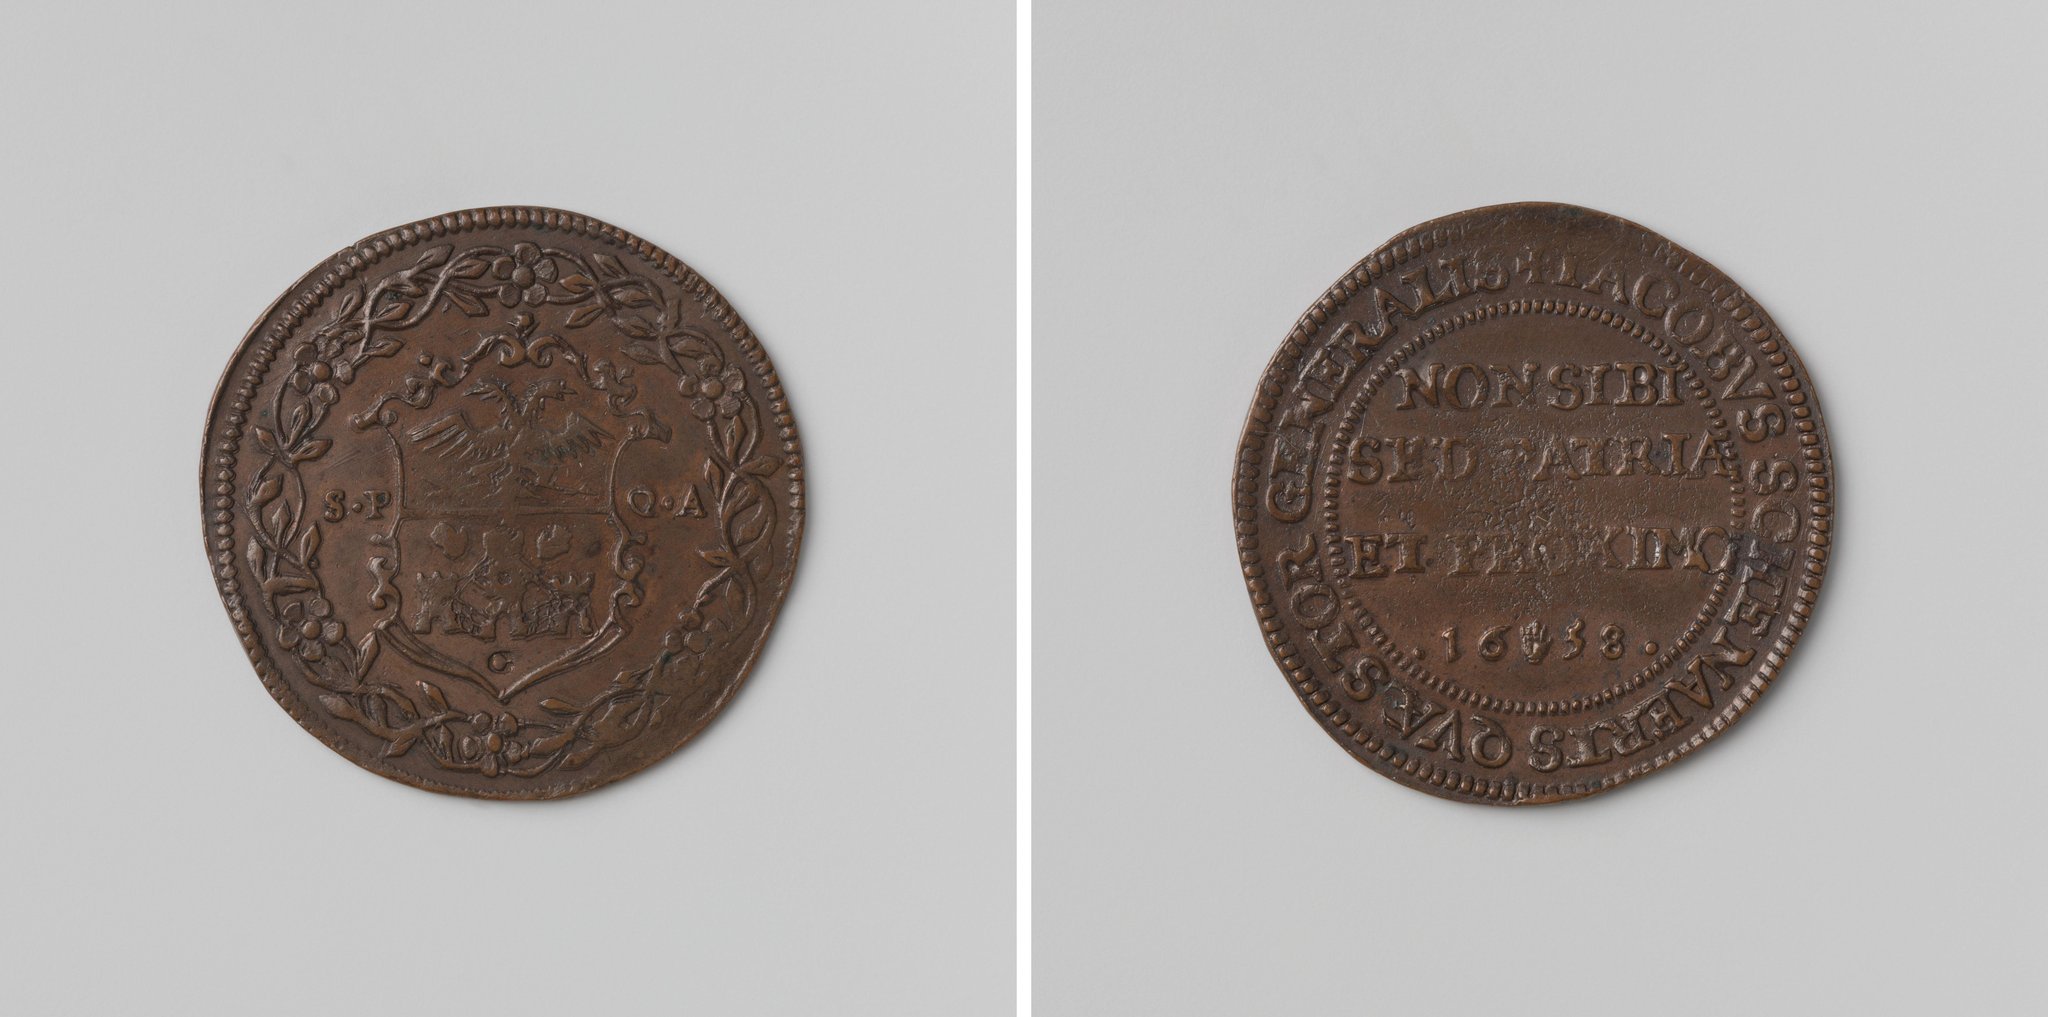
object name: jeton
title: Jacobus Schenaerts, rentmeester-generaal van de stad Antwerpen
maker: Anonymous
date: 1658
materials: copper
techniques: striking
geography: antwerp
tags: antwerp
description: Koperen penning. Voorzijde: wapenschild in cartouche tussen letters S.P.Q.A. binnen krans van bladeren en bloemen; in punt van wapenschild: letter C ingestempeld. Keerzijde: opschrift binnen omschrift.